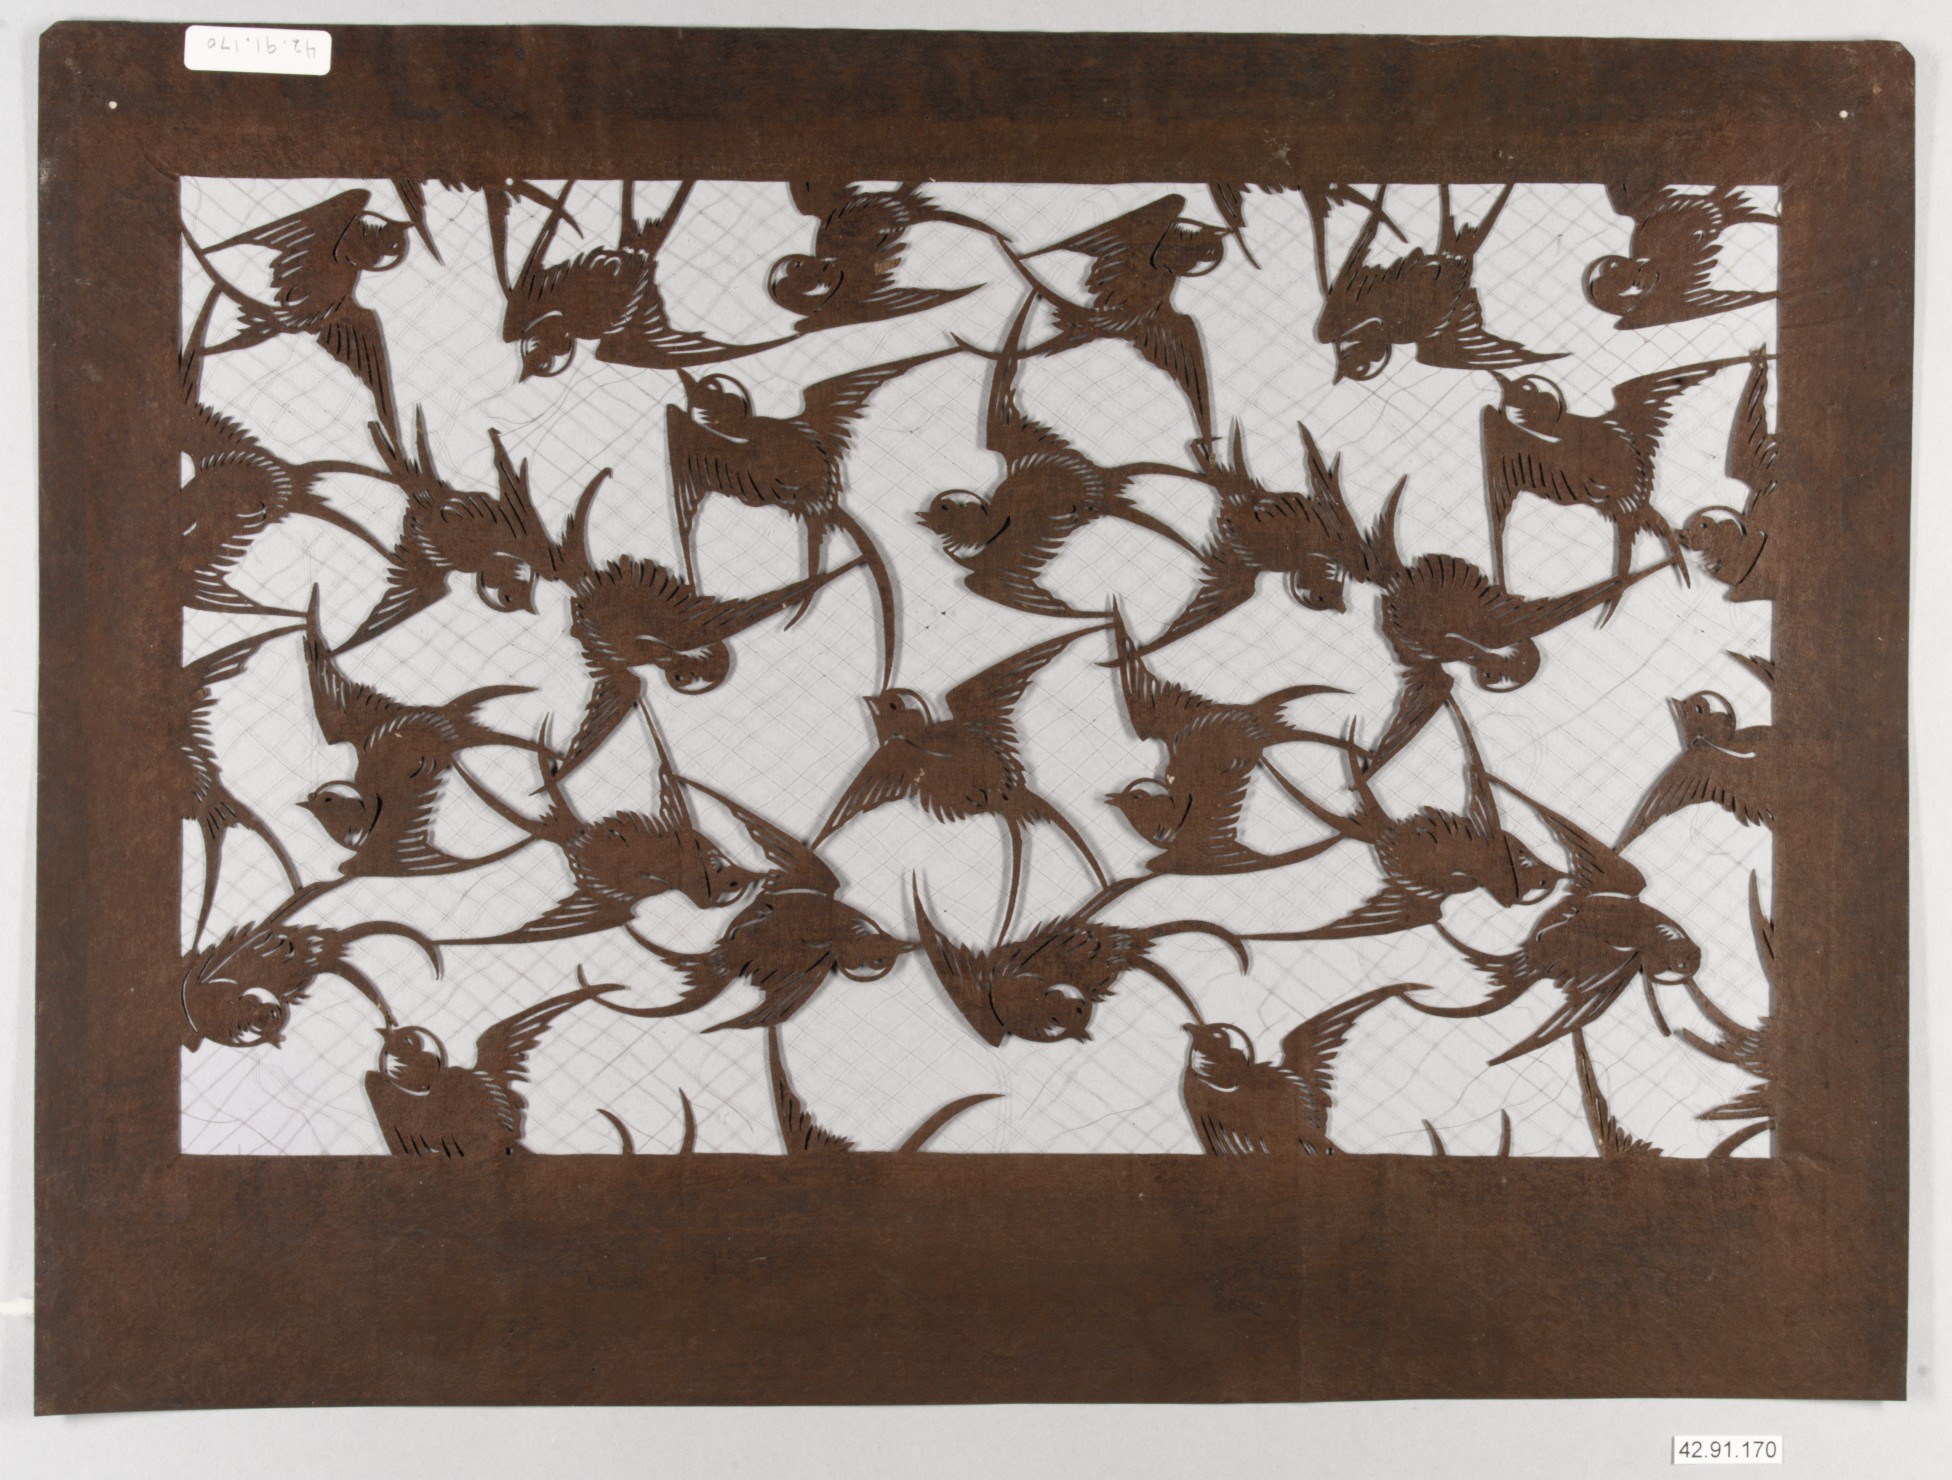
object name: stencil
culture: japanese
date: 1801-1900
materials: paper, silk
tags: birds